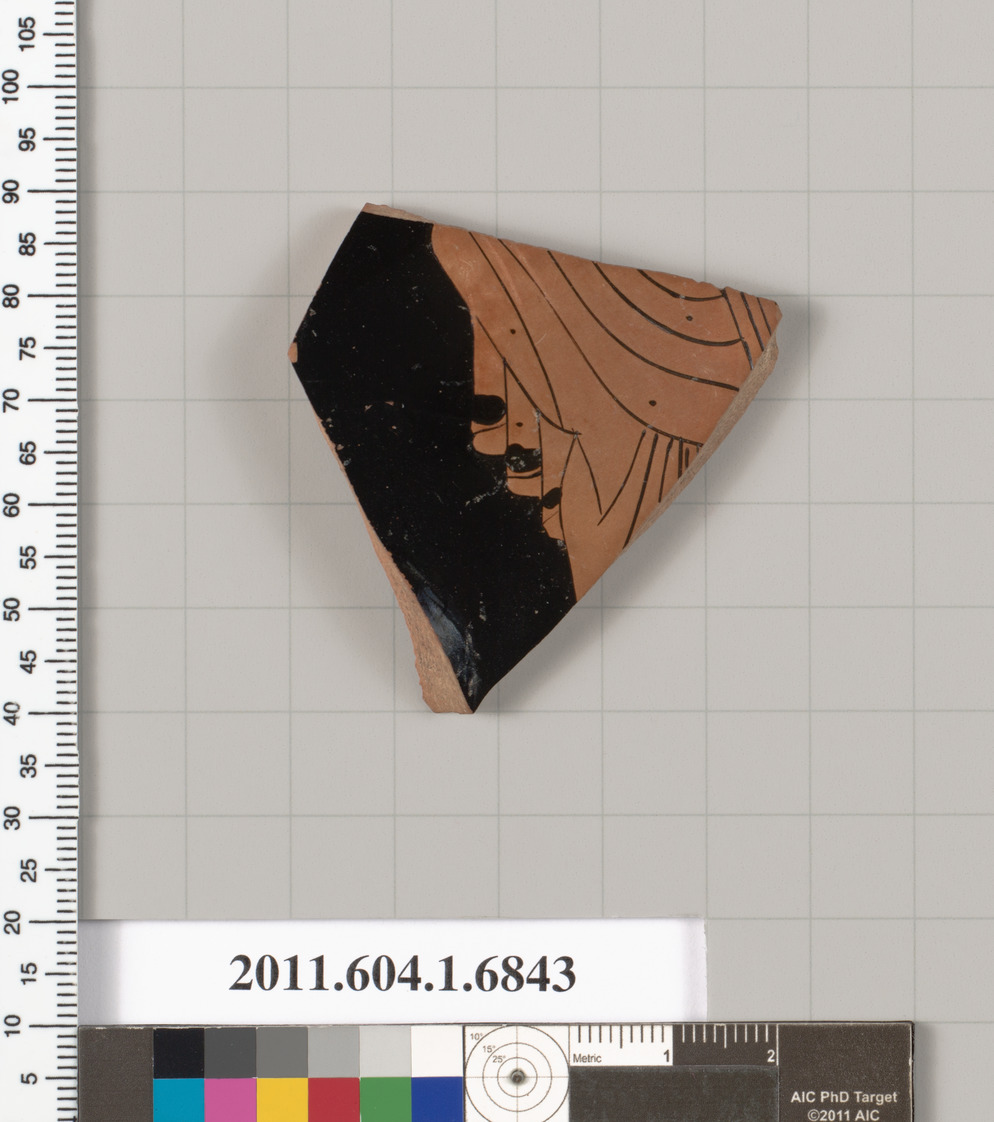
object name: kylix fragment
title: Terracotta fragment of a kylix (drinking cup)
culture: greek, attic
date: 490-470 BCE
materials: terracotta